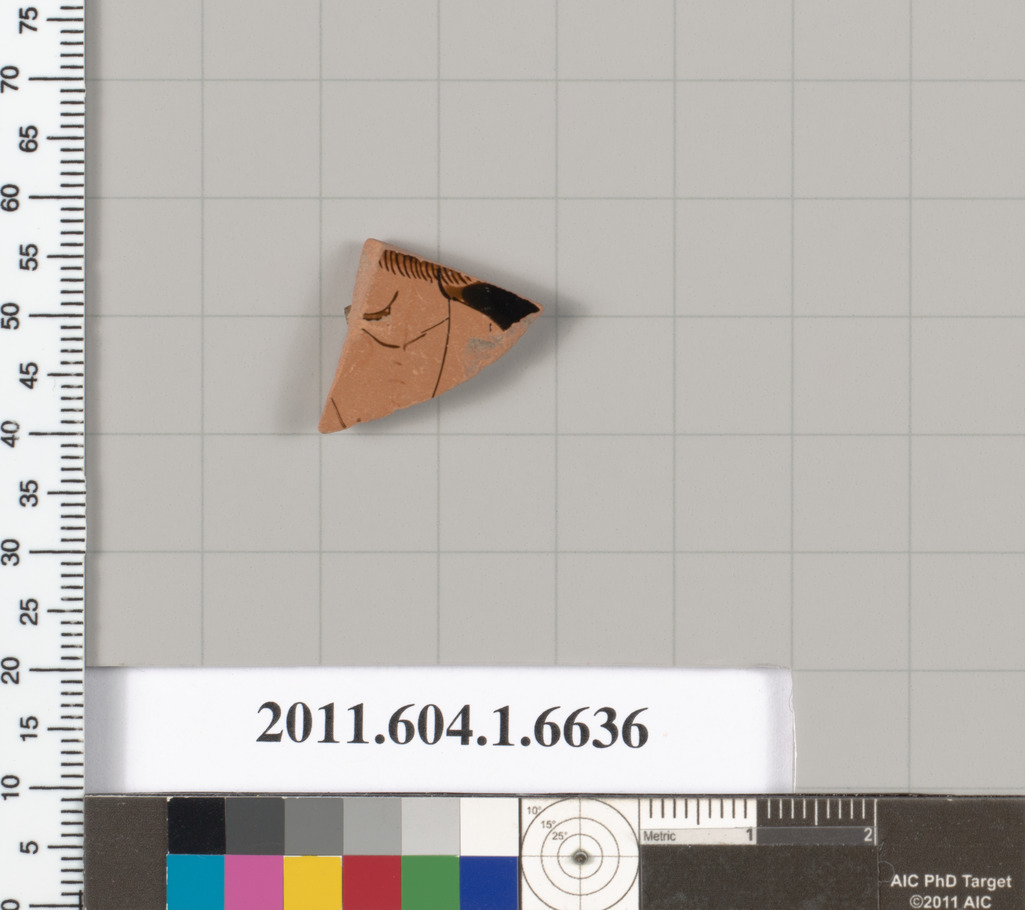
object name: kylix fragment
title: Terracotta fragment of a kylix (drinking cup)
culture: greek, attic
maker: brygos painter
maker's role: artist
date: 490-470 BCE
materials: terracotta